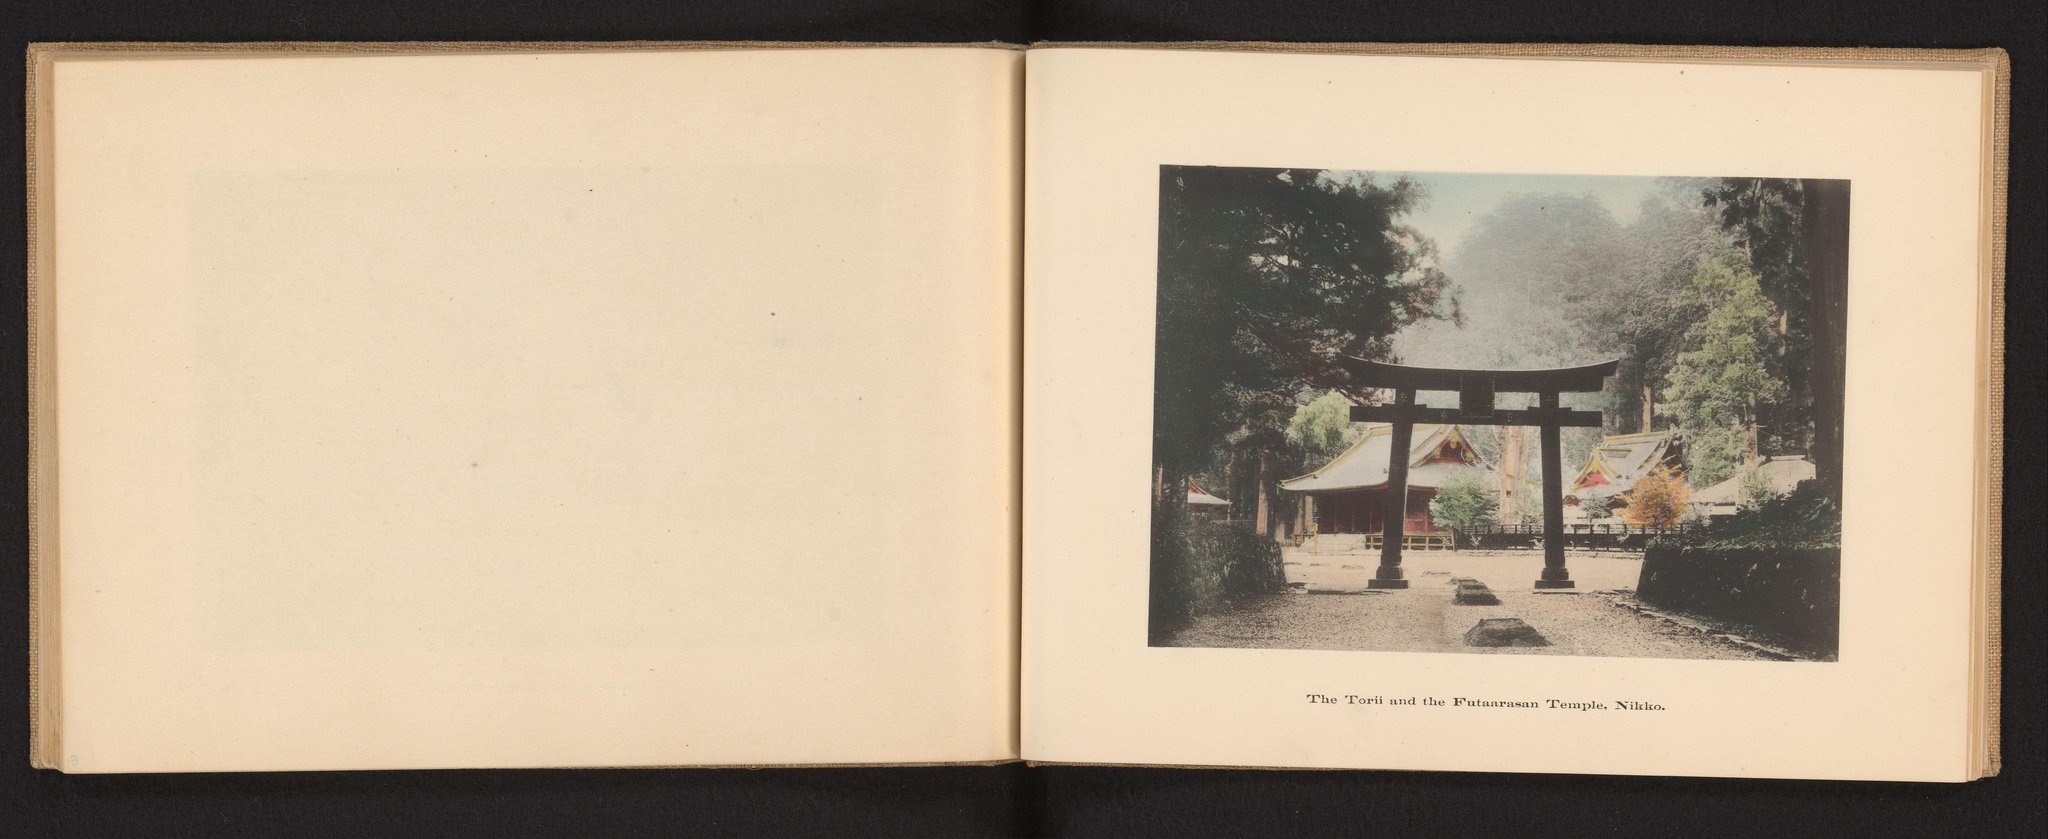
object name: page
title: The Torii and the Futaarasan Temple, Nikko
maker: kōzaburō tamamura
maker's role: fotograaf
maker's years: 1856-1923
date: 1895-1905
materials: paper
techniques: photograph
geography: nikko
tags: temple, shrine ~ hinduism, buddhism, jainism, gate, entrance